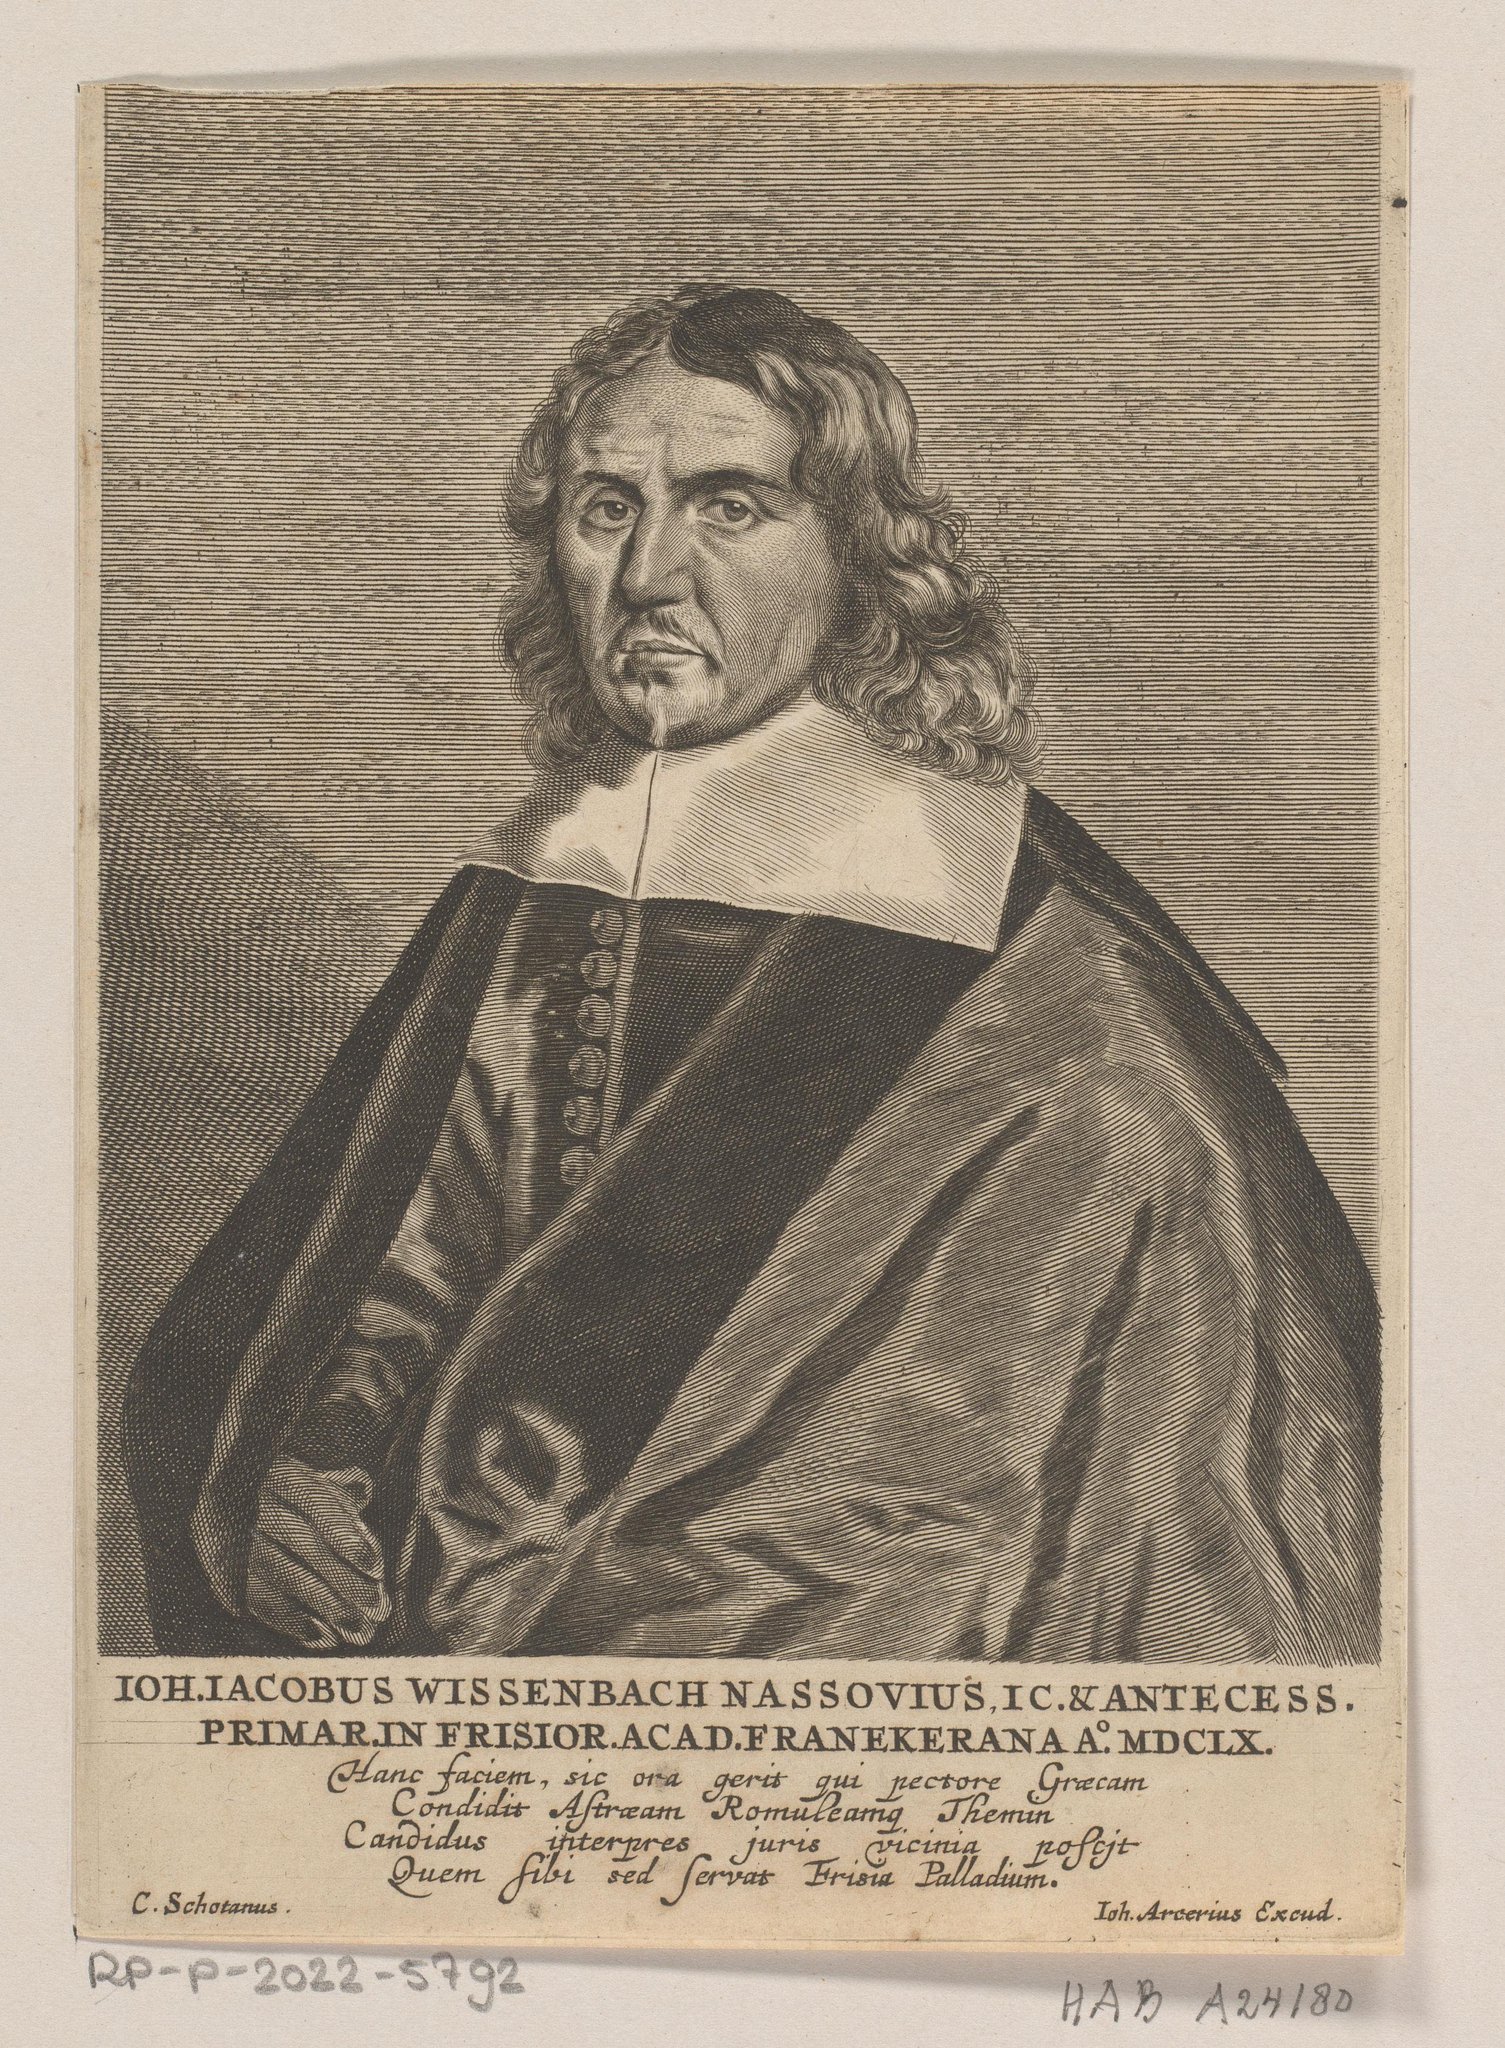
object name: print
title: Portret van Johannes Jacobus Wissenbach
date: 1660-1680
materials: paper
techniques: engraving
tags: historical persons, professor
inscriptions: signature: ‘Ioh.Arcerius Excud.’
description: Met zesregelig onderschrift in het Latijn.